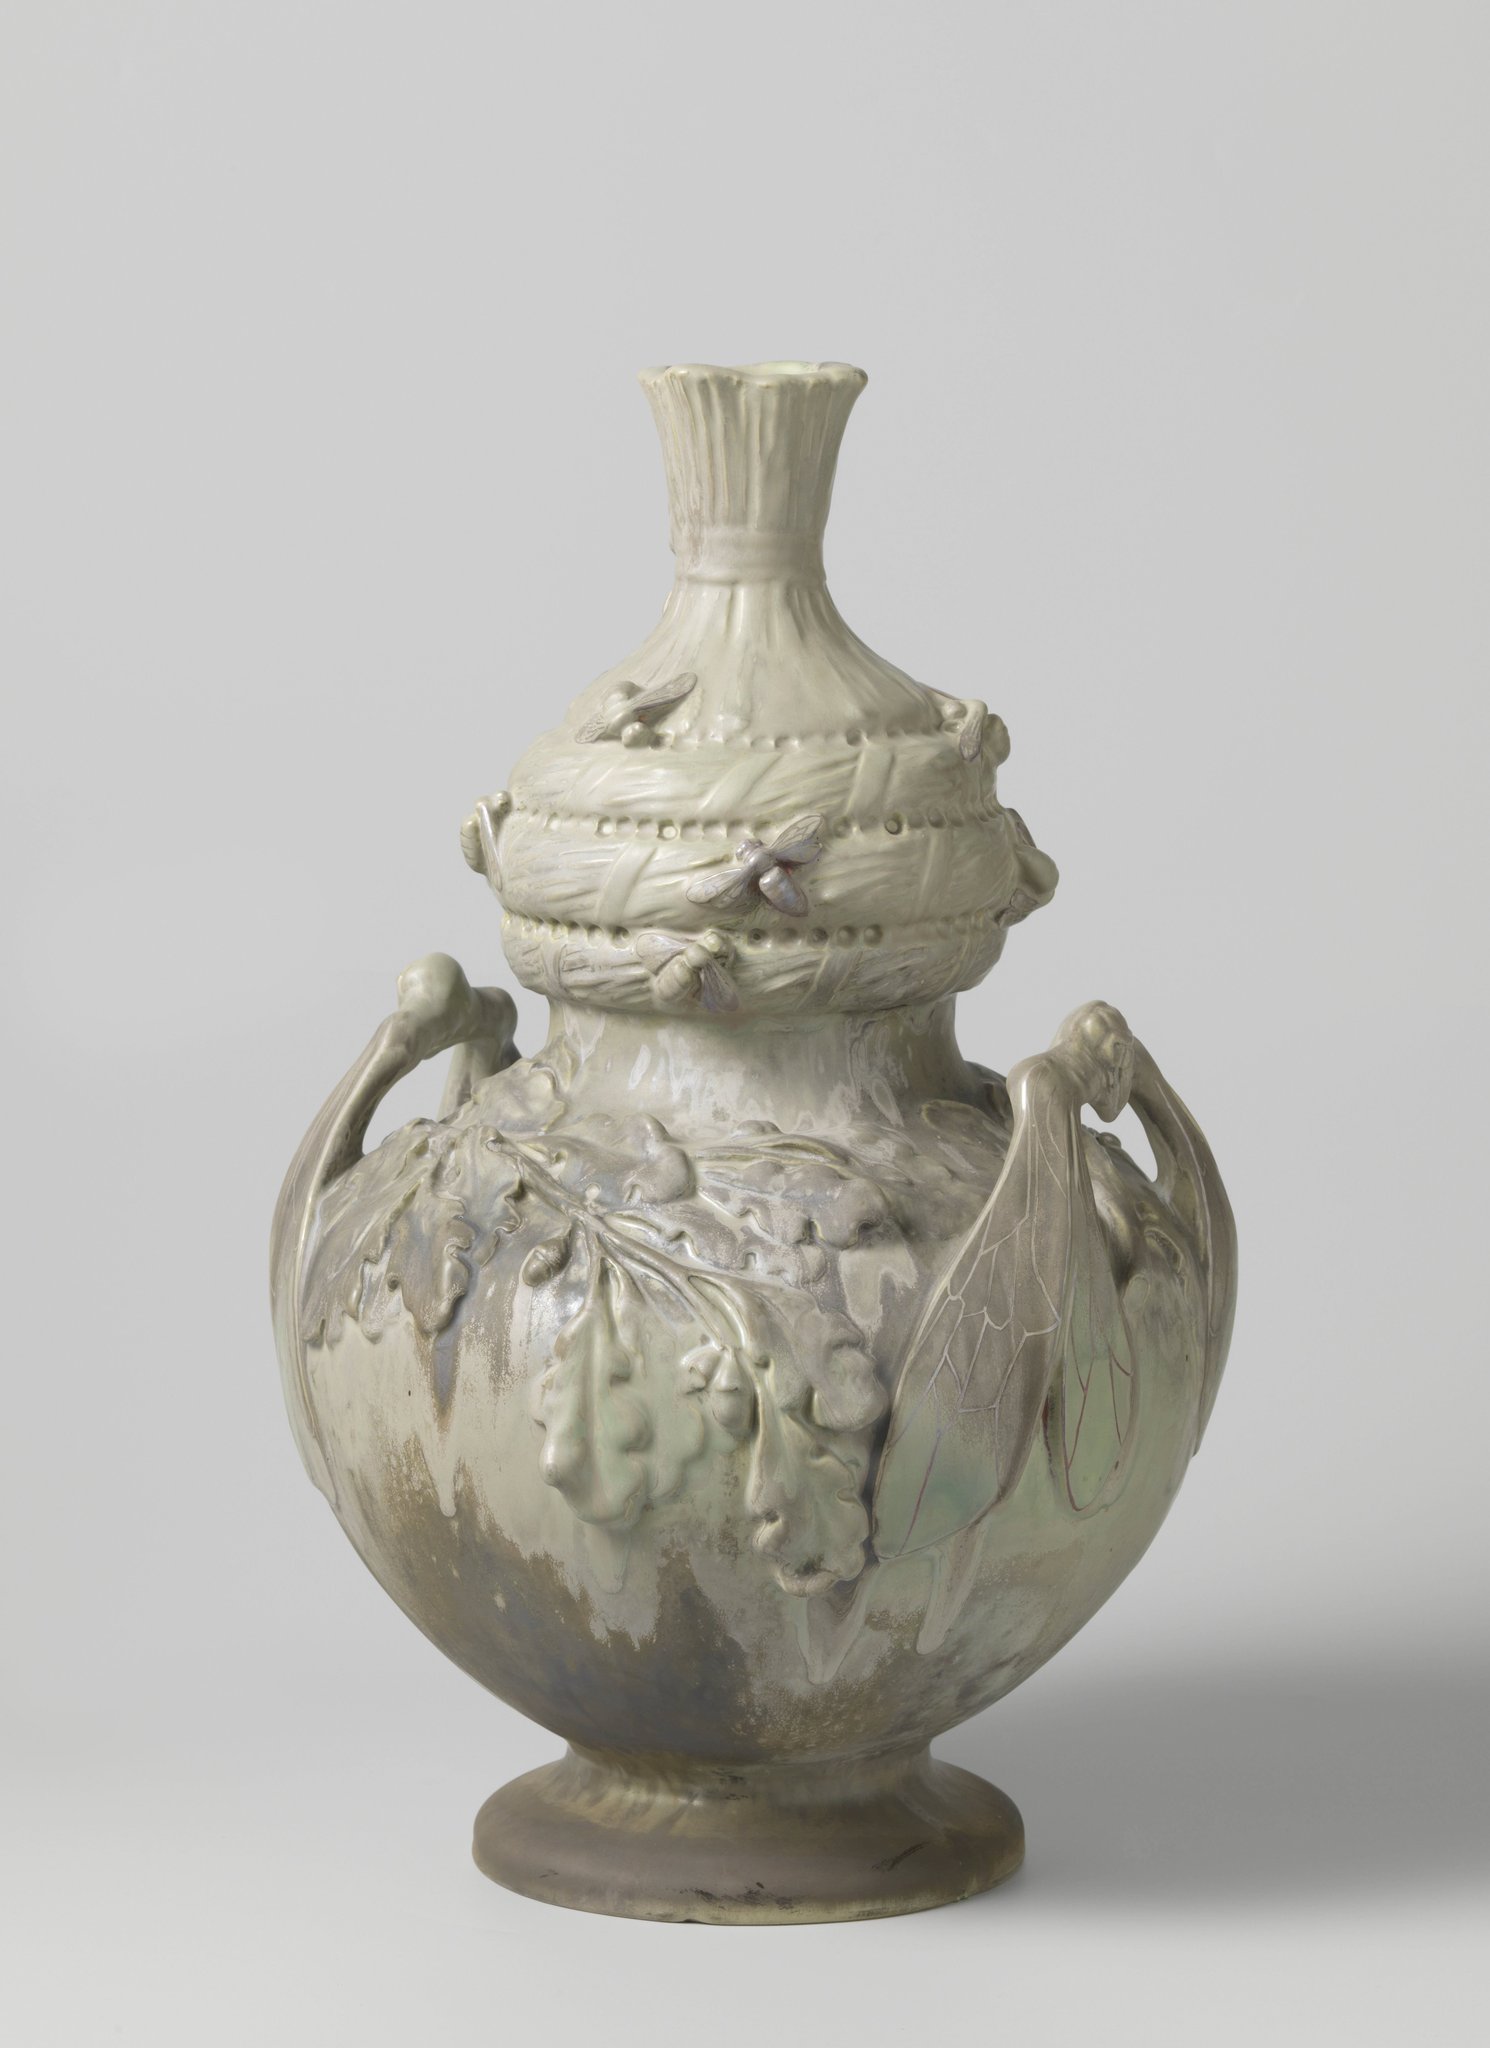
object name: vase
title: Vaas, bolvormig, met hals in de vorm van een bijenkorf met tien bijen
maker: ernest bussière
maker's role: designer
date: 1903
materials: earthenware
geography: lunéville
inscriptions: mark: ‘K.G // Luneville // Bussière ; I met horizontale streep eronder, met letter A ; elders een 5.’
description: Vaas van aardewerk, bolvormig op ingesnoerde voet, met een hals in de vorm van een bijenkorf met tien bijen in reliëf, met rieten bedekking. Op het bolvormige lichaam takken met eikenbladeren en eikels in reliëf en twee bijen, eveneens in reliëf aan de voorzijde. De vaas heeft twee oren in de vorm van bijenvleugels. De gehele vaas is bedekt met een groen en grijs gedekte engobe met gedeeltelijk luster over een rode glazuur. Bij de vaas hoort een voet (B) van kastanjehout met bronzen plaque met opschrift.